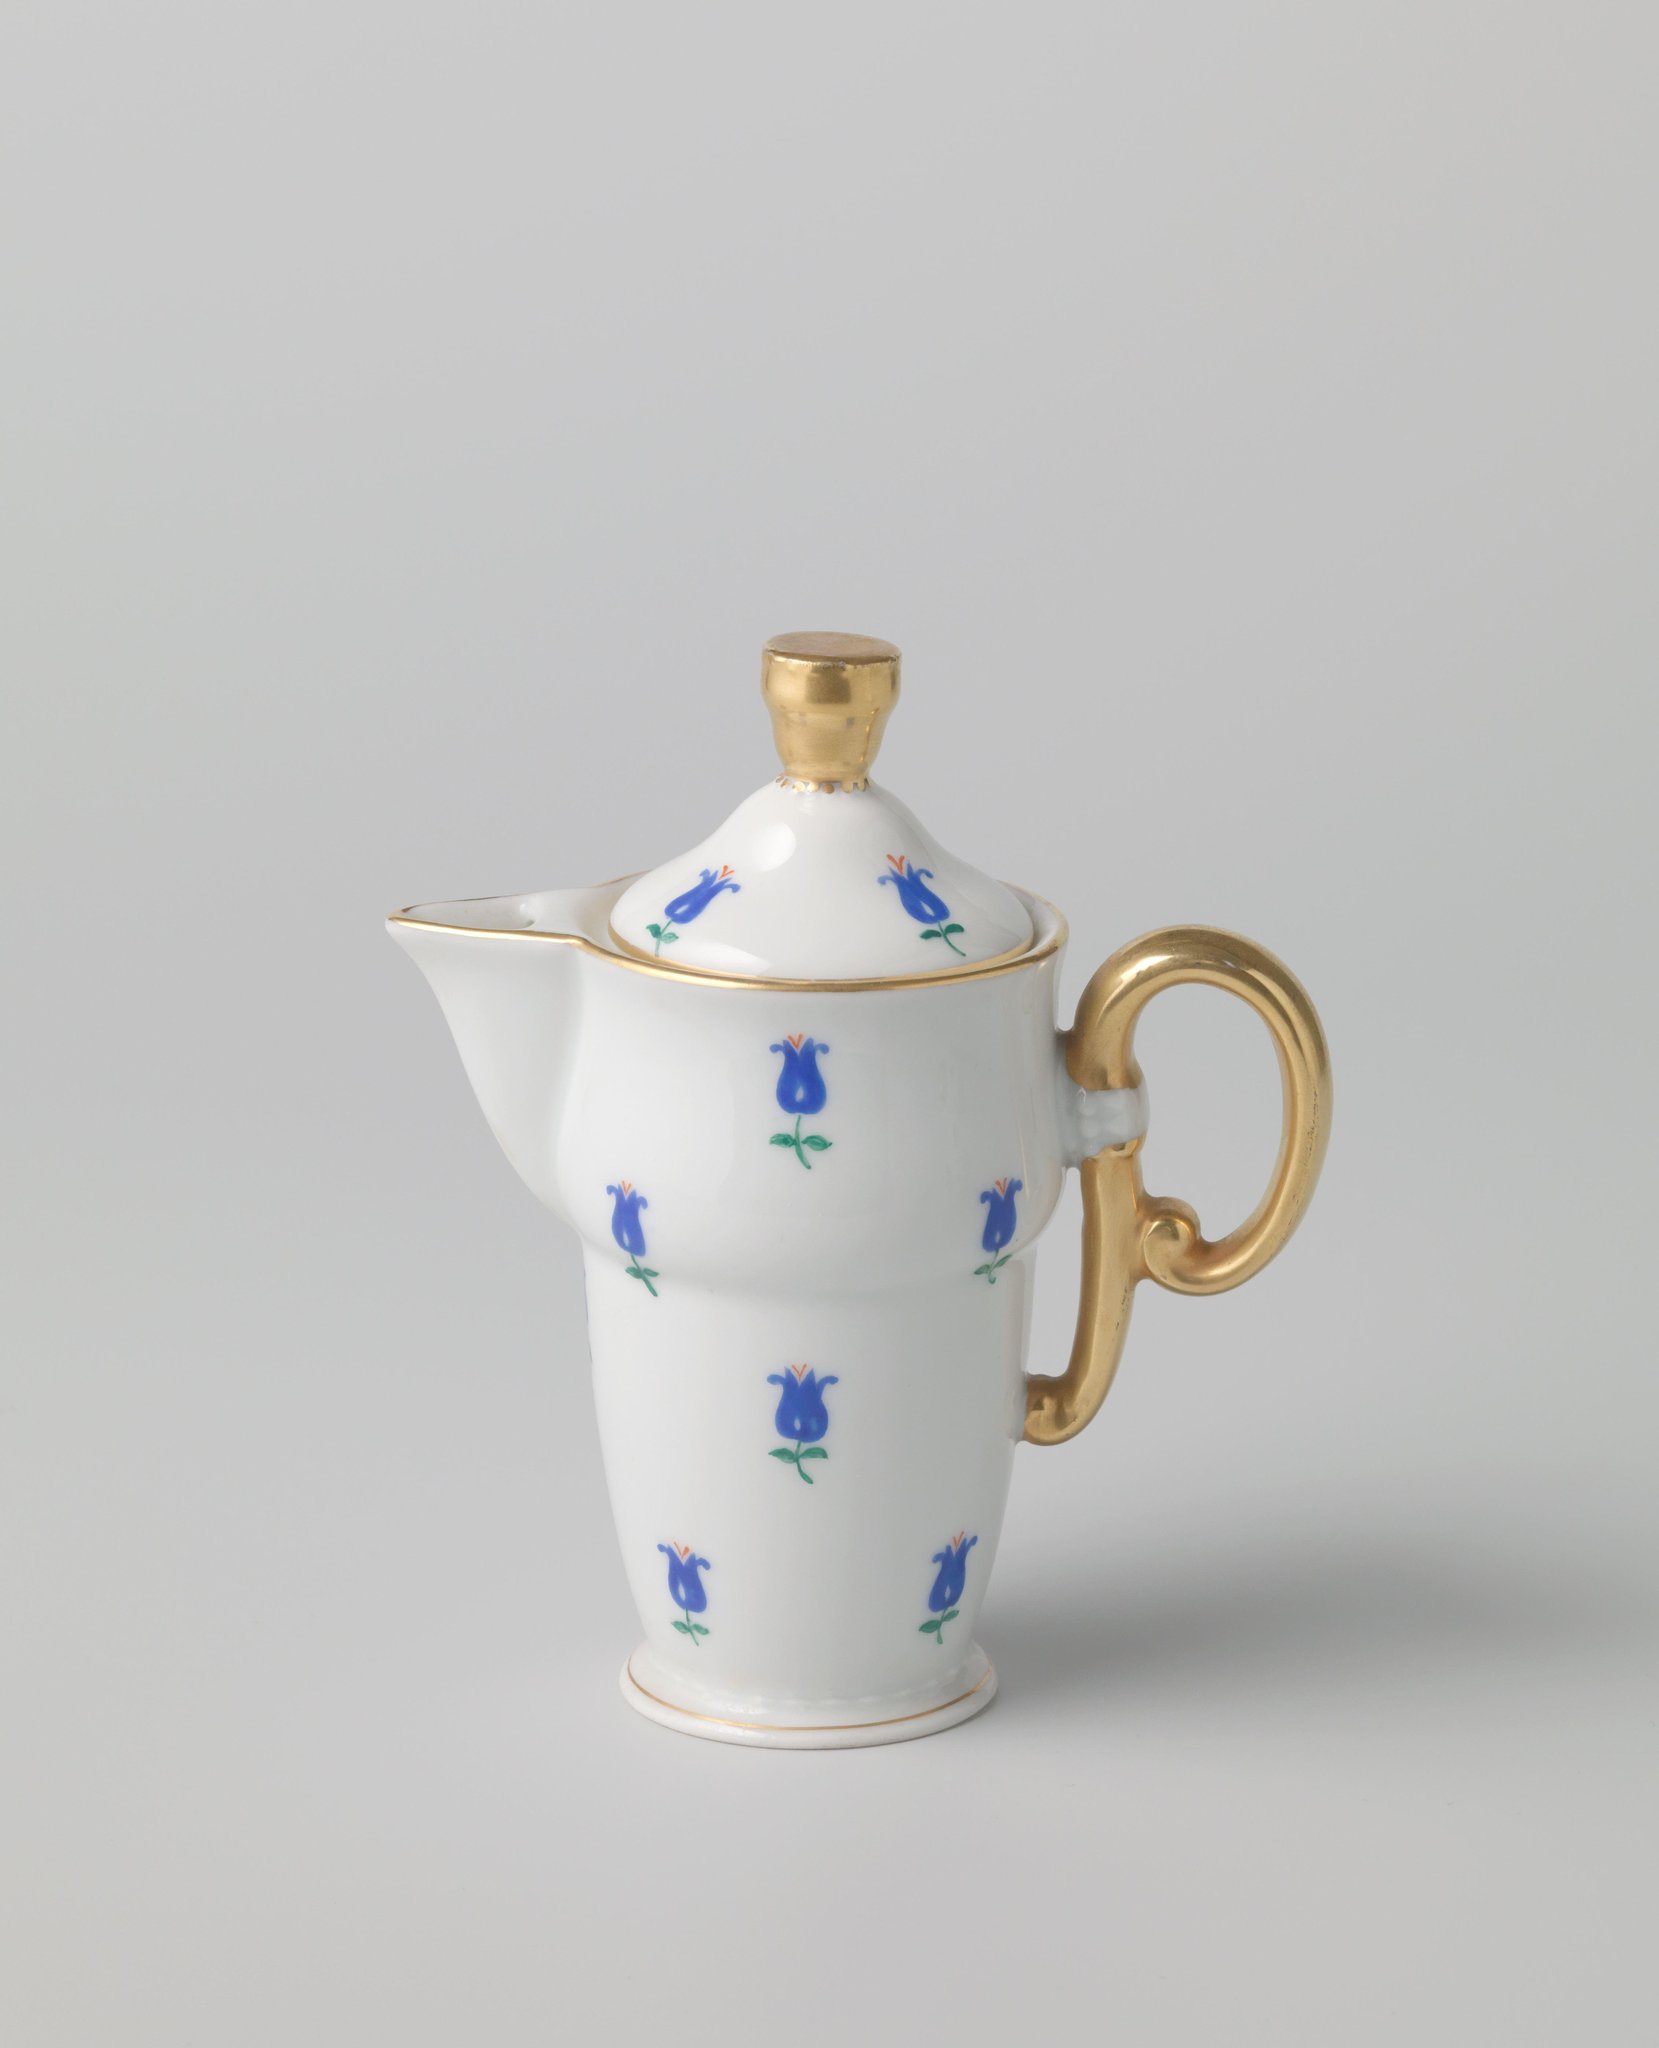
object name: milk jug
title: Milkjug with flowers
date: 1935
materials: glaze, gold, paint, porcelain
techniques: firing, forming, gilding, turning, vitrification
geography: karlovy vary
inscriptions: mark: ‘gekruiste hamers met kroon/ EPIAG PIRKENHAMMER CECHOSLOW/ 5857’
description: Melkkan van porselein op iets spreidende voet met een licht uitlopend lichaam dat net boven de helft verdikt en uitloopt in een wijde nek, driehoekige tuit vanuit de nek en P-vormig oor. Beschilderd op het glazuur in blauw, rood, groen en goud. De buik en nek met blauwe bloemen en een gouden oor. Gouden lijn op de voet en de rand. Deksel met dezelfde decoratie en conische, gouden dekselknop. Gemerkt op de onderzijde met de gekruiste hamers met kroon, de tekst 'EPIAG PIRKENHAMMER CECHOSLOW' en het nummer 5857.